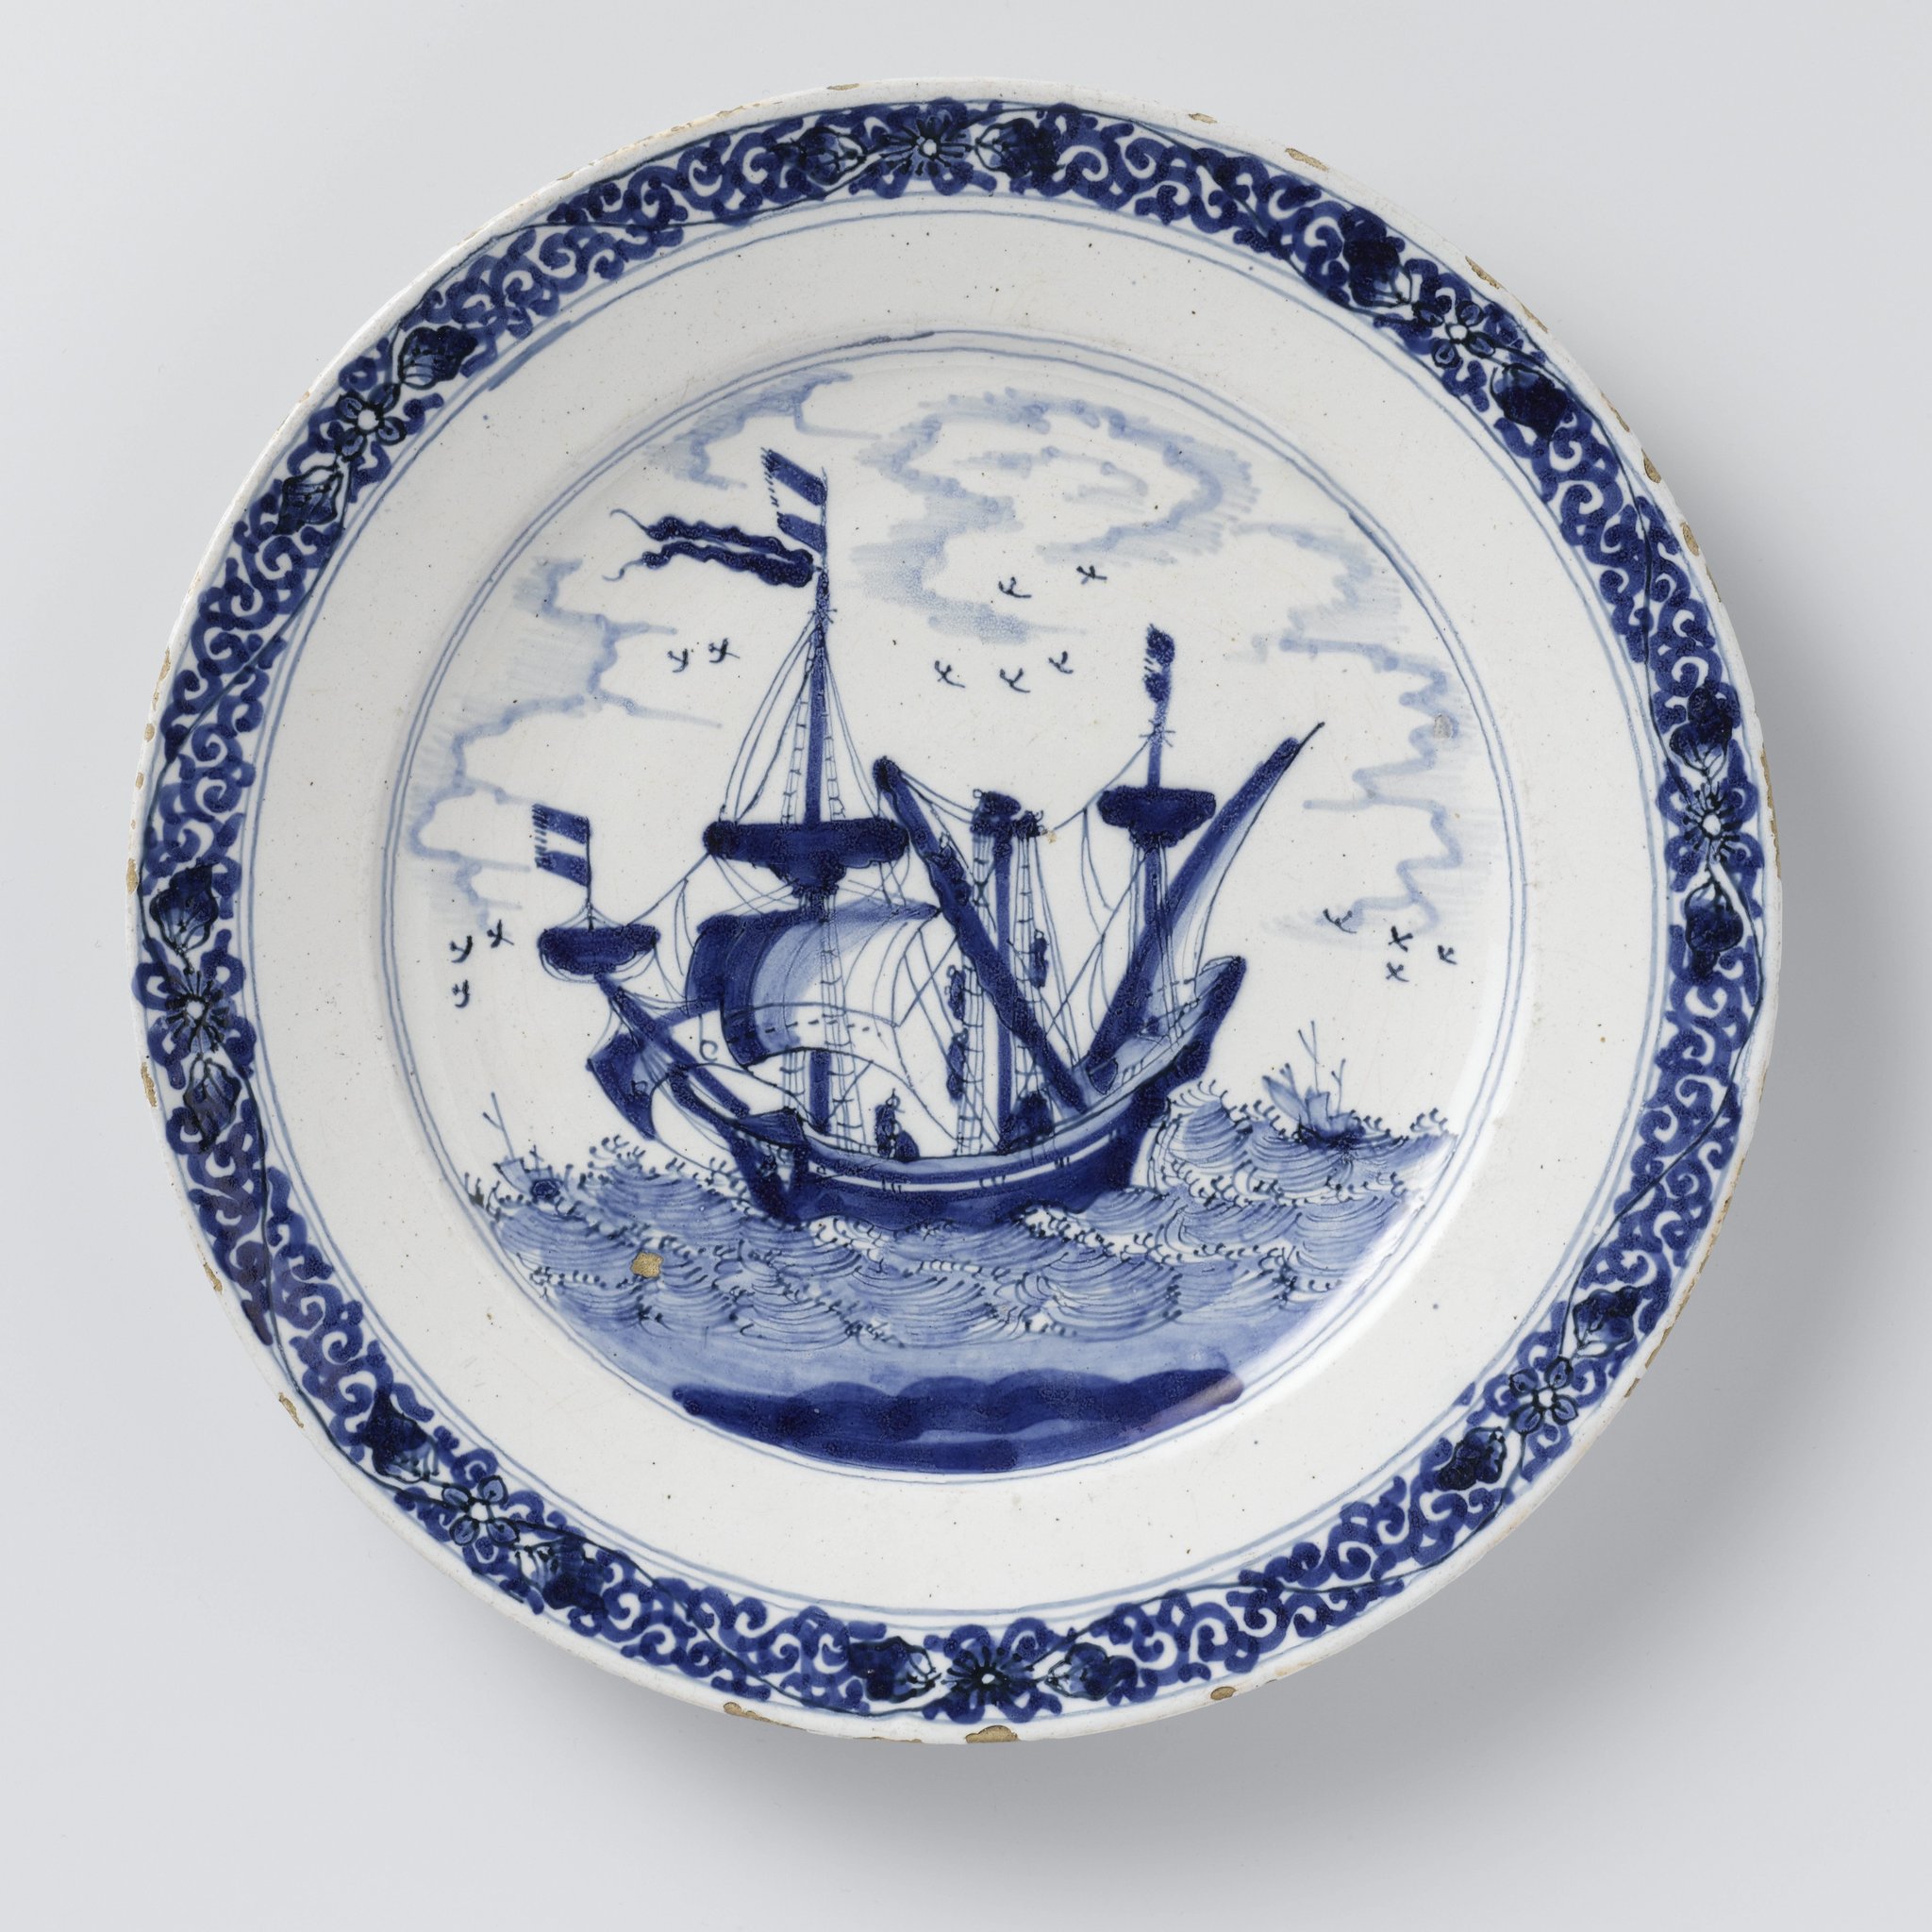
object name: plate dish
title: Bord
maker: Anonymous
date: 1680-1710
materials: earthenware, glaze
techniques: painted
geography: delft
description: Rond bord van blauw beschilderde faience, met op het plat vier zeilende schepen. Bij het bord horen drie identieke borden met de invnrs. BK-NM-11168-a, BK-NM-11168-c en BK-NM-11168-d.